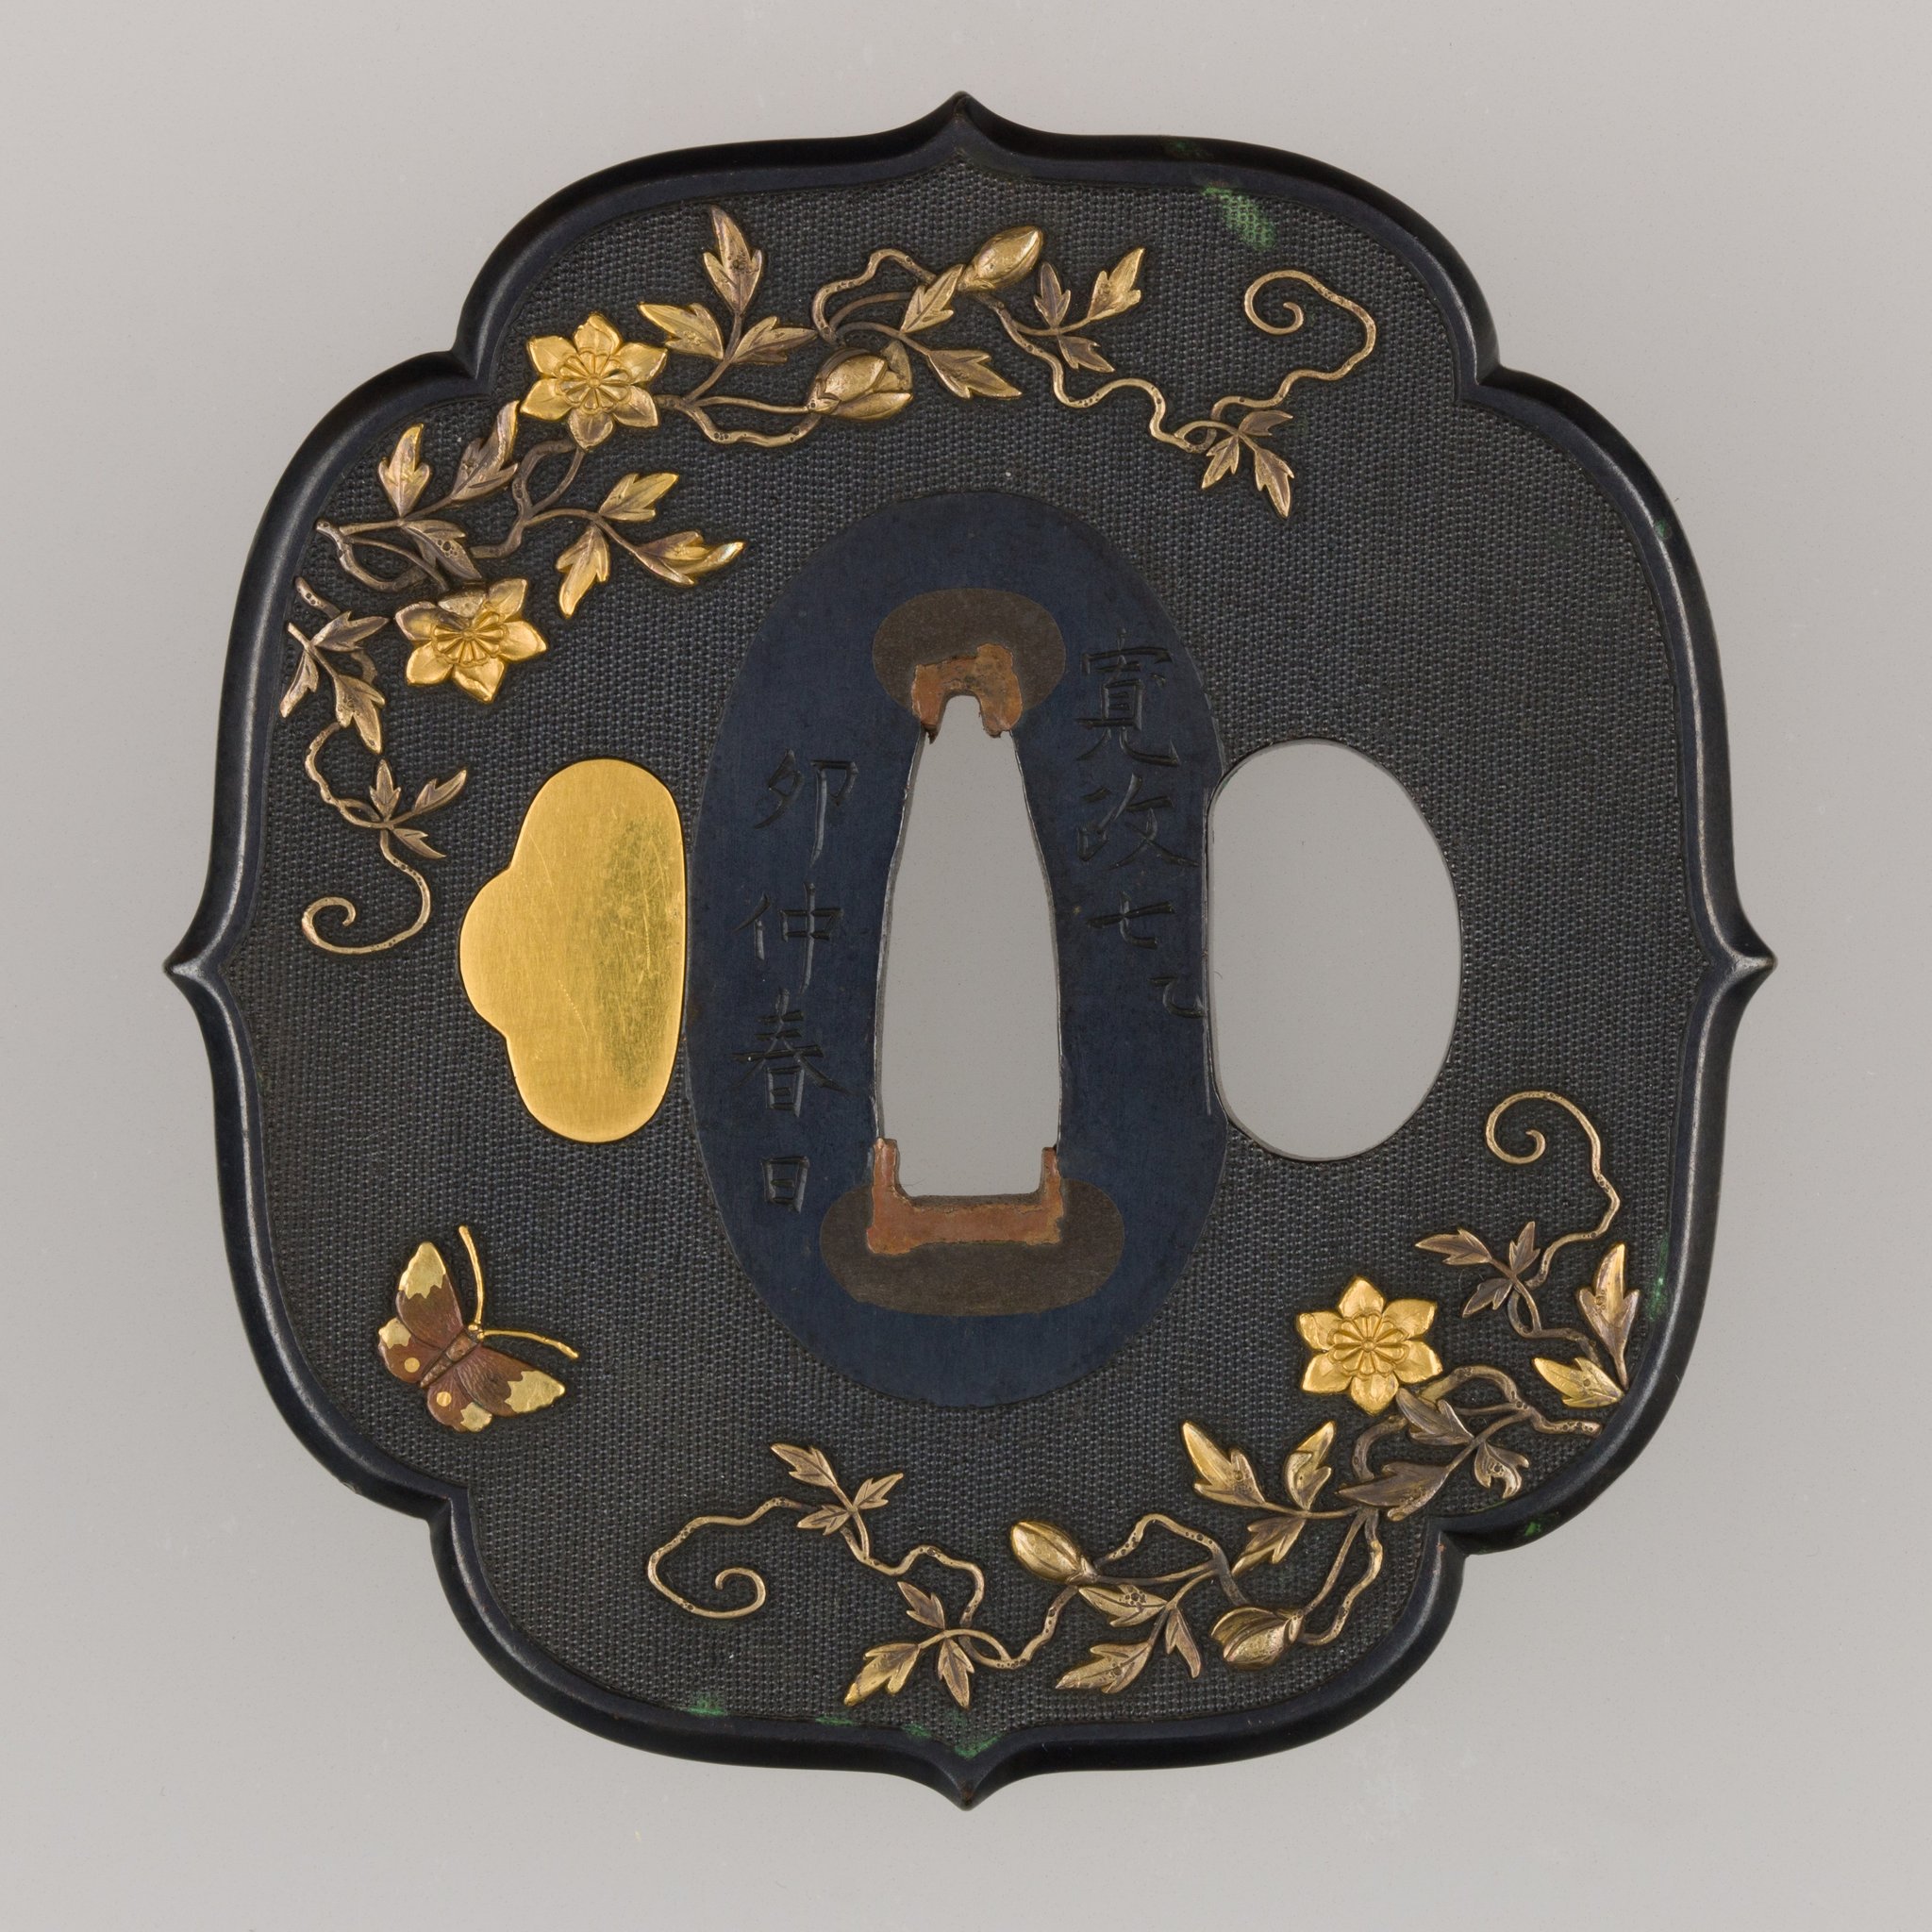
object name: sword guard tsuba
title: Sword Guard (Tsuba)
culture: japanese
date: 1795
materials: copper, gold alloy, silver alloy, gold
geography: japan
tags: butterflies,flowers